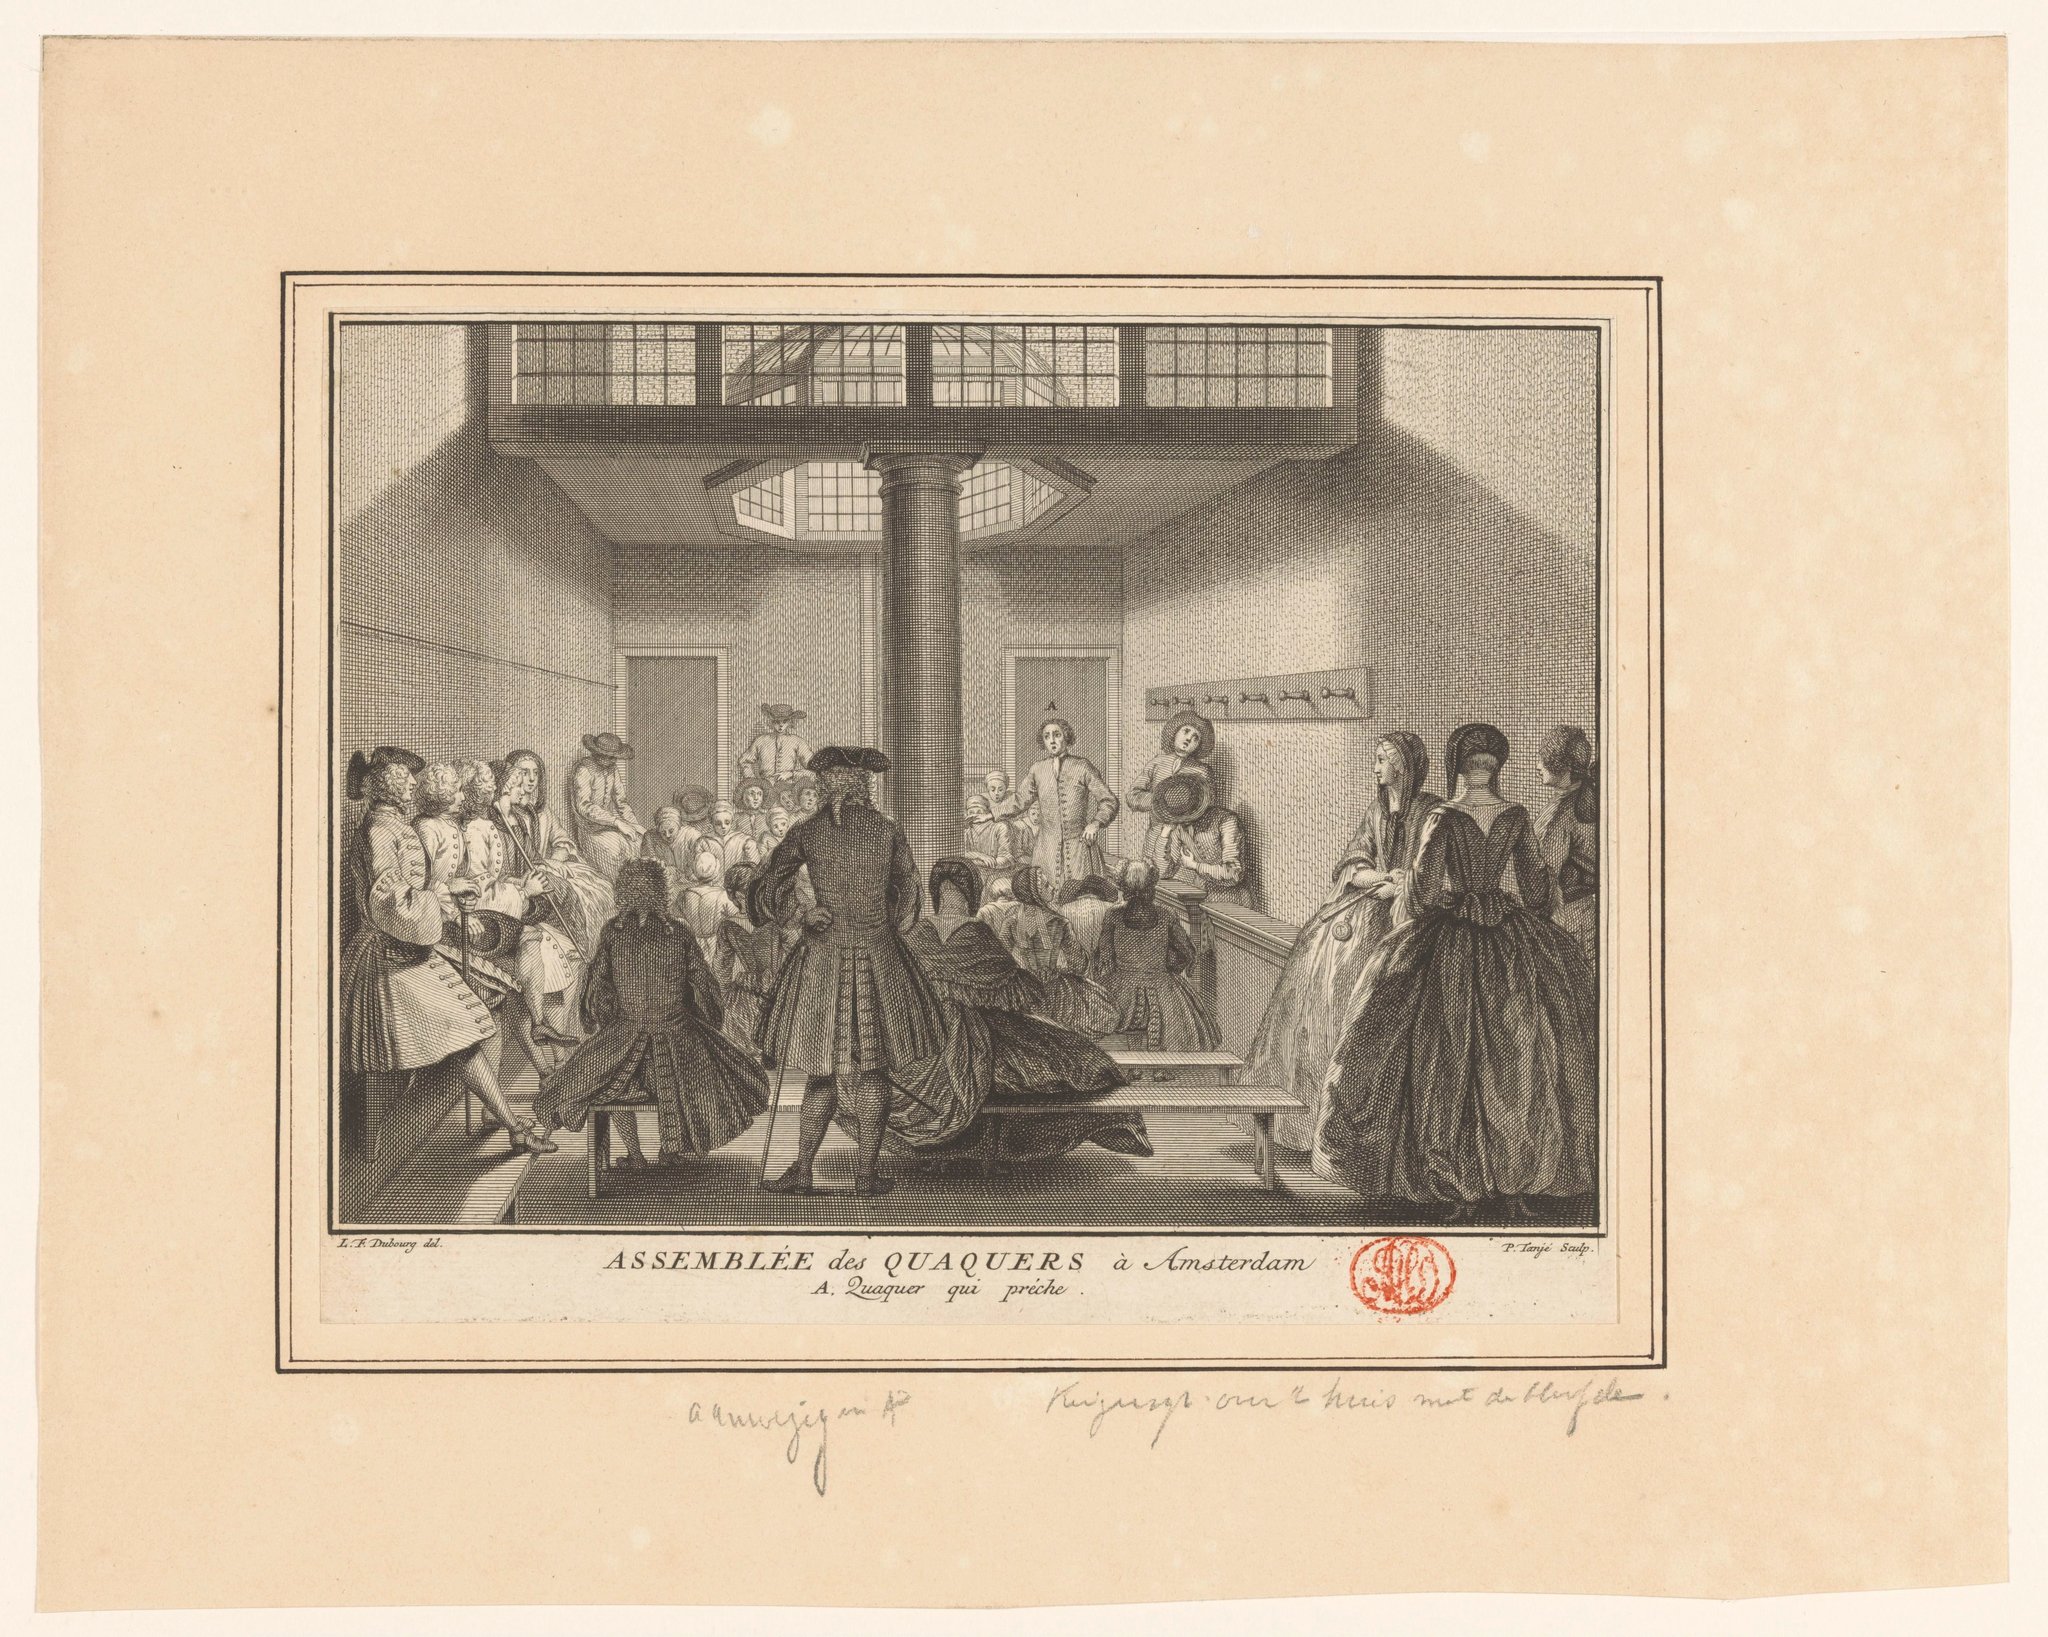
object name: book illustration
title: Bijeenkomst van Quakers te Amsterdam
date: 1736-1738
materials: paper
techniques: engraving, etching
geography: amsterdam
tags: interior of church, protestant churches and denominations (with name)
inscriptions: collector's mark: Lugt 195, collector's mark: Lugt 2233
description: Prent ook gebruikt in: Picart, Bernard. Ceremonies et coutumes religieuses de tous les peuples du monde (...). 10 delen. Amsterdam: Jean Frederic Bernard, 1723-1743, dl. 4 (1736), na p. 130. En in de Nederlandse vertaling: Picart, Bernard en Abraham Moubach. Naaukeurige beschryving der uitwendige godtsdienst-plichten, kerk-zeden en gewoontens van alle volkeren der waereldt : in een historisch verhaal (...). 6 delen. 's-Gravenhage: Rutgert Christoffel Alberts, 1727-1738, dl. 6 (1738), na p. 118. En waarschijnlijk ook in de Engelse vertaling.